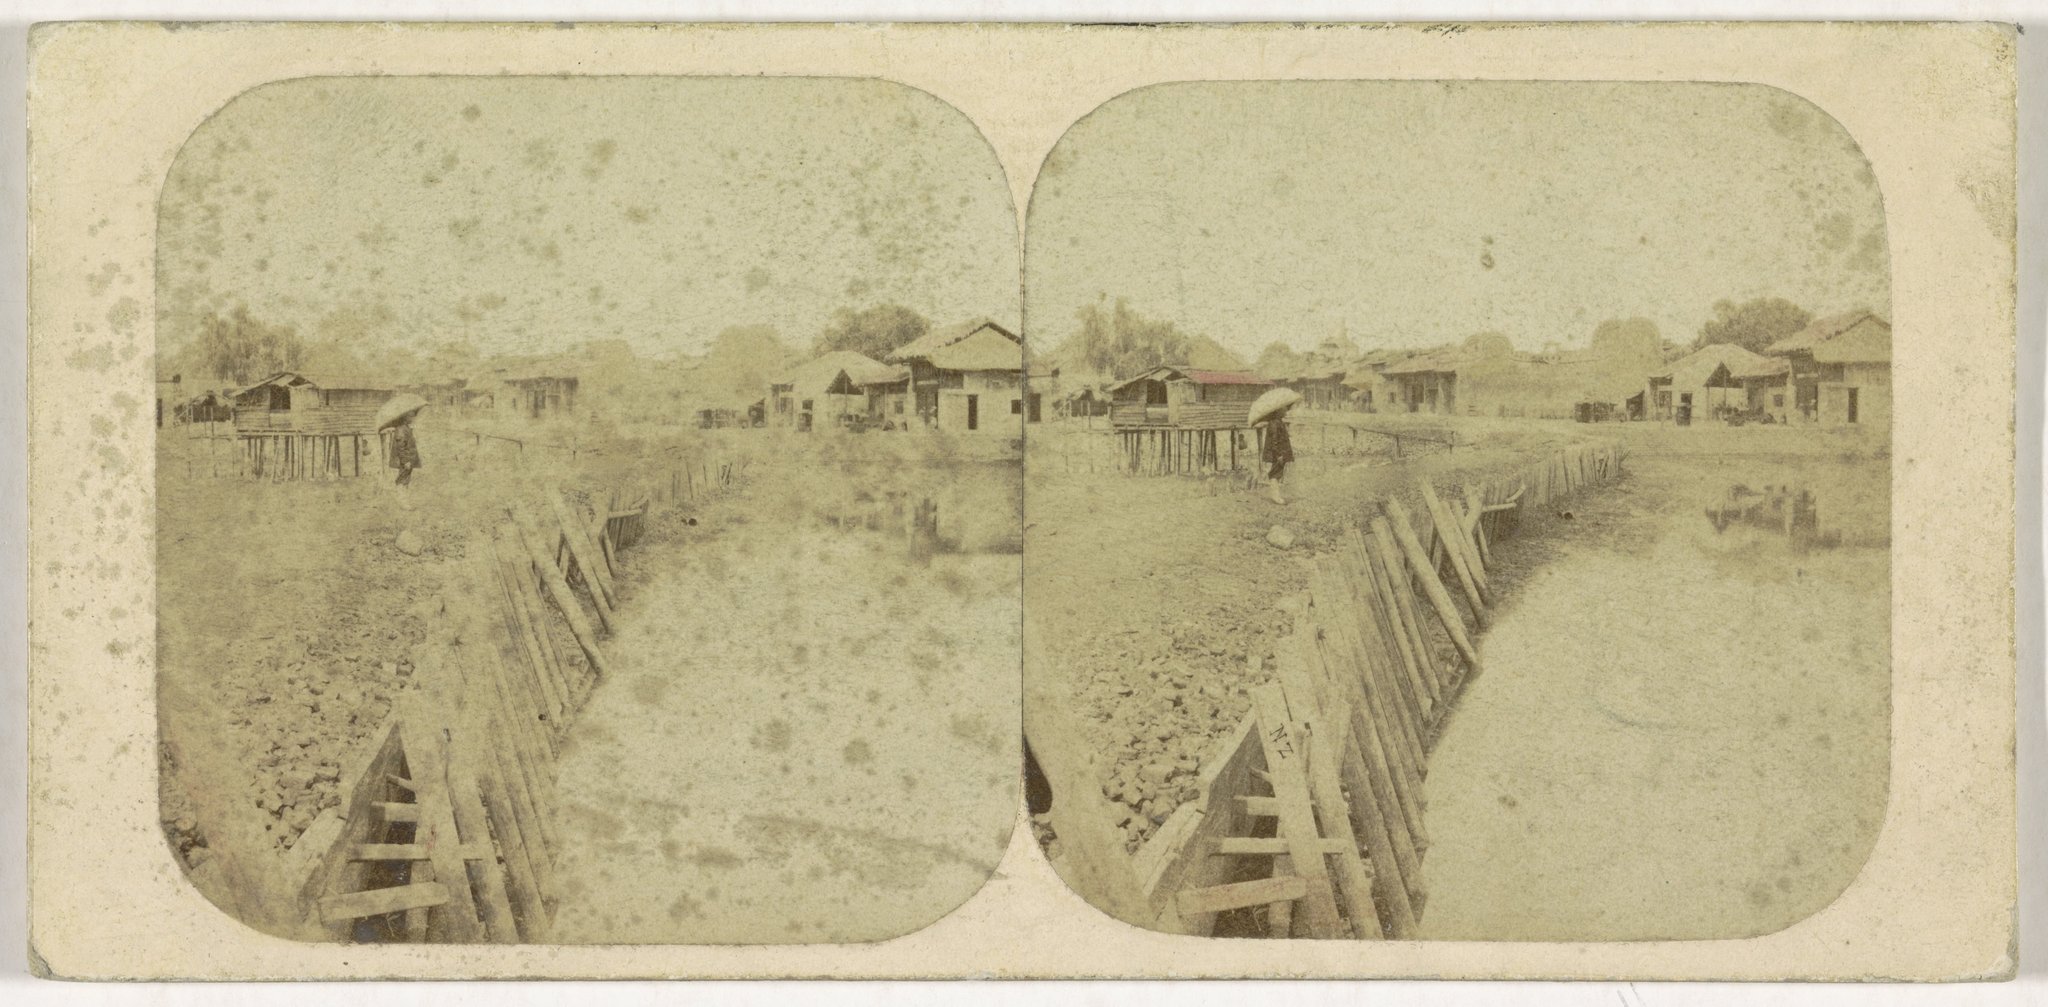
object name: stereograph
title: Views in China Canton The Jetty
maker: felice beato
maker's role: fotograaf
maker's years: 1825-1909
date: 1850-1860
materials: photographic support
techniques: albumen print, hand coloring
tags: kanton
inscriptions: number: ‘8’, title: ‘Views in China / 7 / Canton. / The Jetty.’